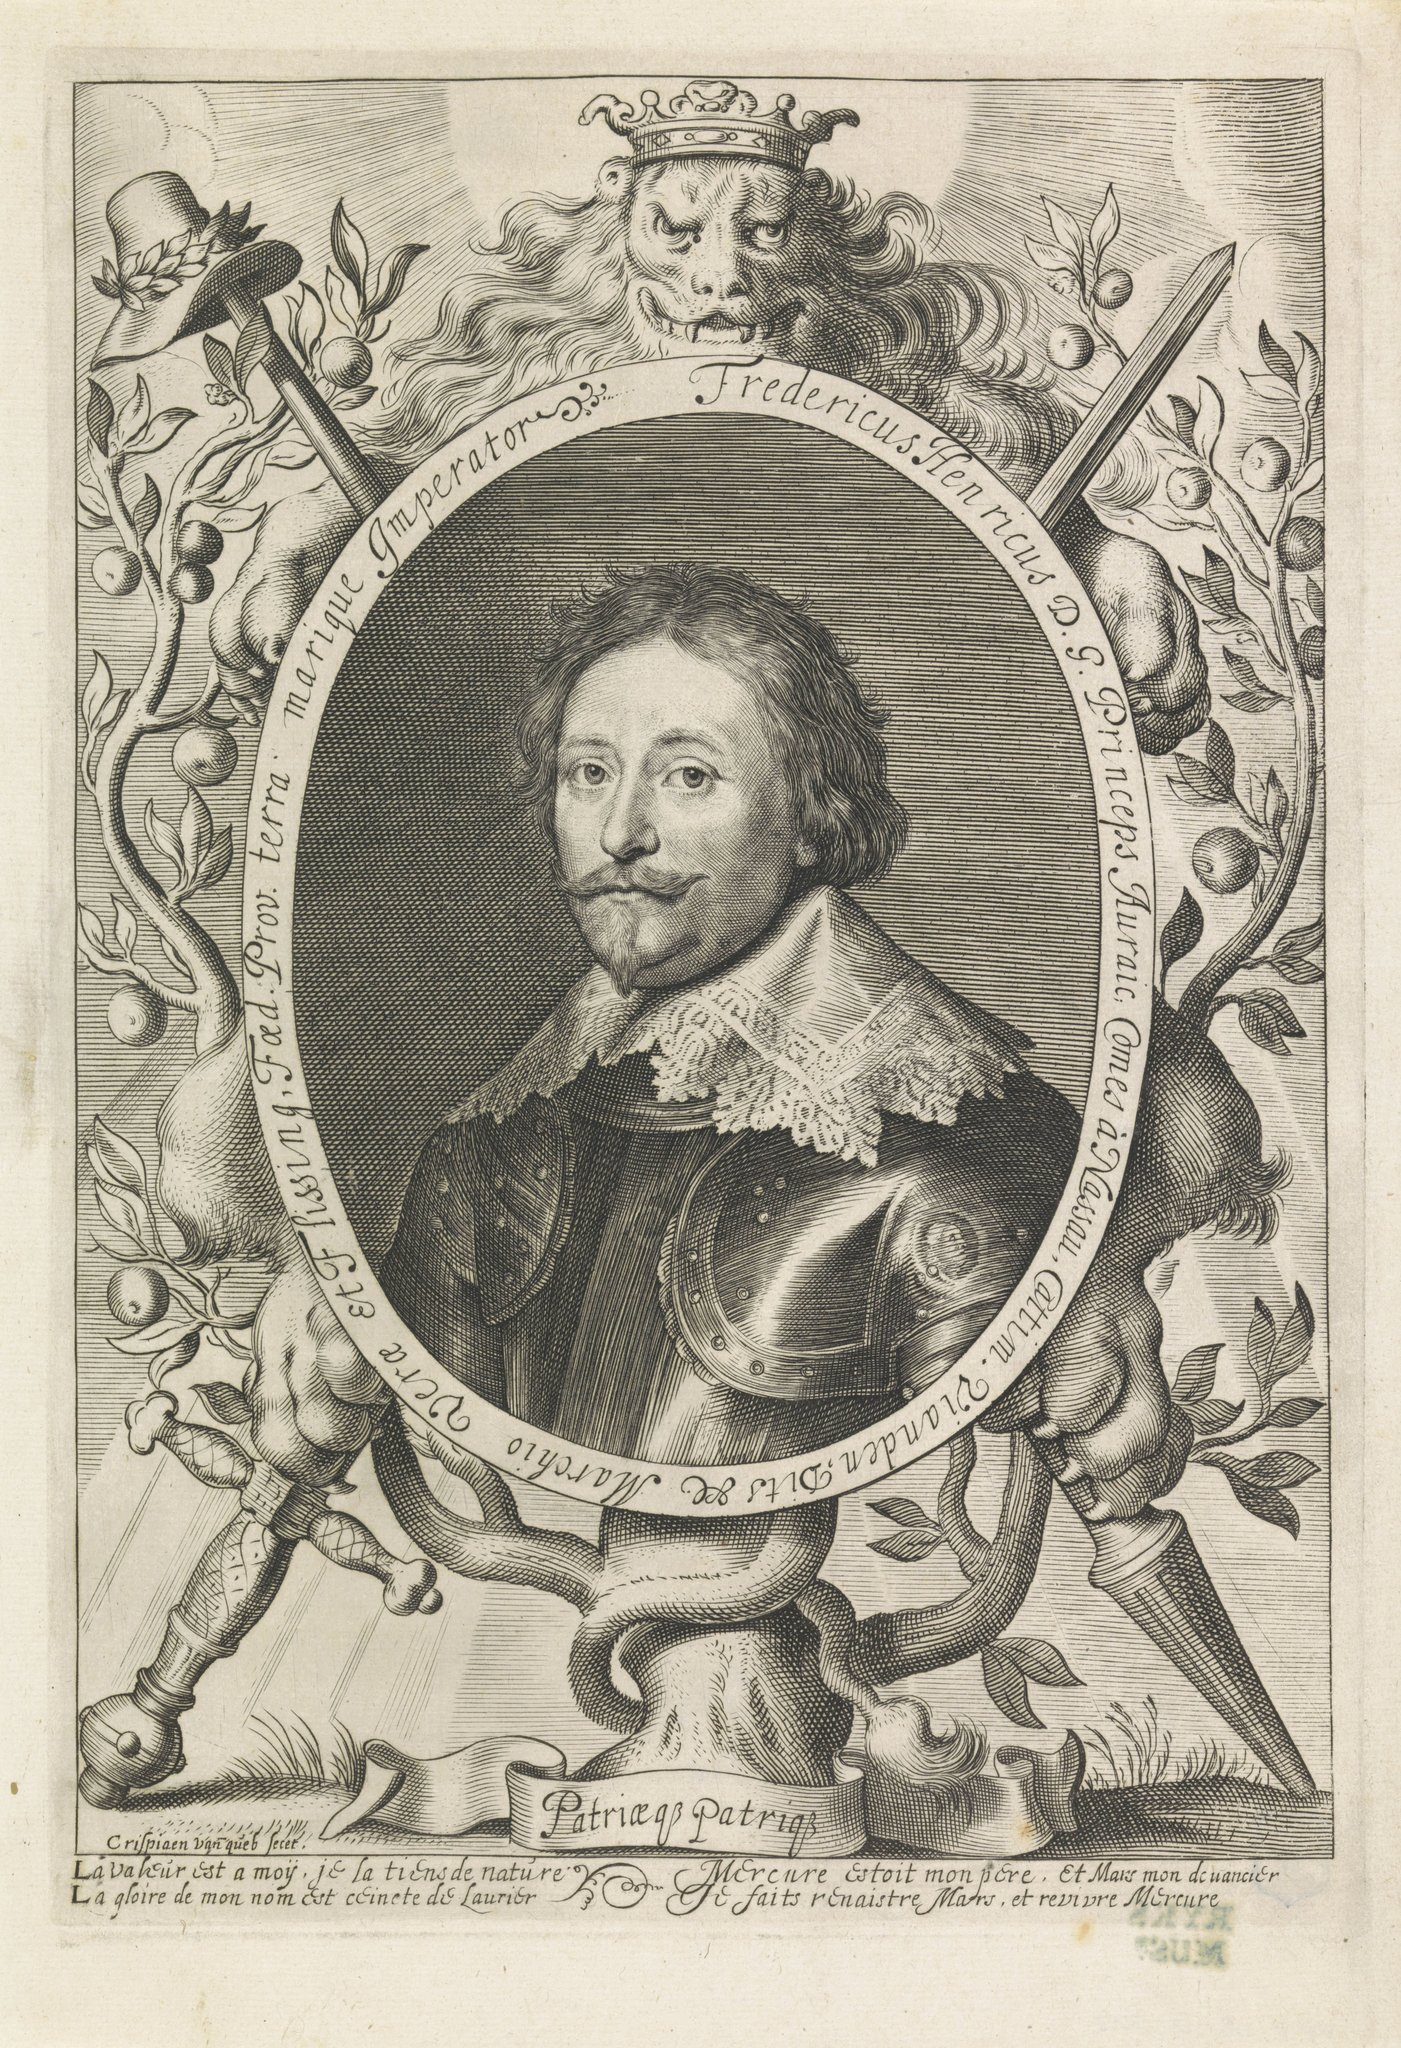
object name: print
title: Portret van Frederik Hendrik, prins van Oranje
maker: crispijn van den queborn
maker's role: print maker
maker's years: 1595-1652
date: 1624-1652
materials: paper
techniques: engraving, etching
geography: the hague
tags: frederick henry (prince of orange)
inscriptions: collector's mark: Lugt 963, collector's mark: Lugt 2165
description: Portret van Frederik Hendrik in een ovaal met randschrift. Geheel in een afzonderlijk gegraveerde omlijsting met een aantal allegorische objecten. Op een banderol zijn lijfspreuk. In de ondermarge twee regels Franse tekst.